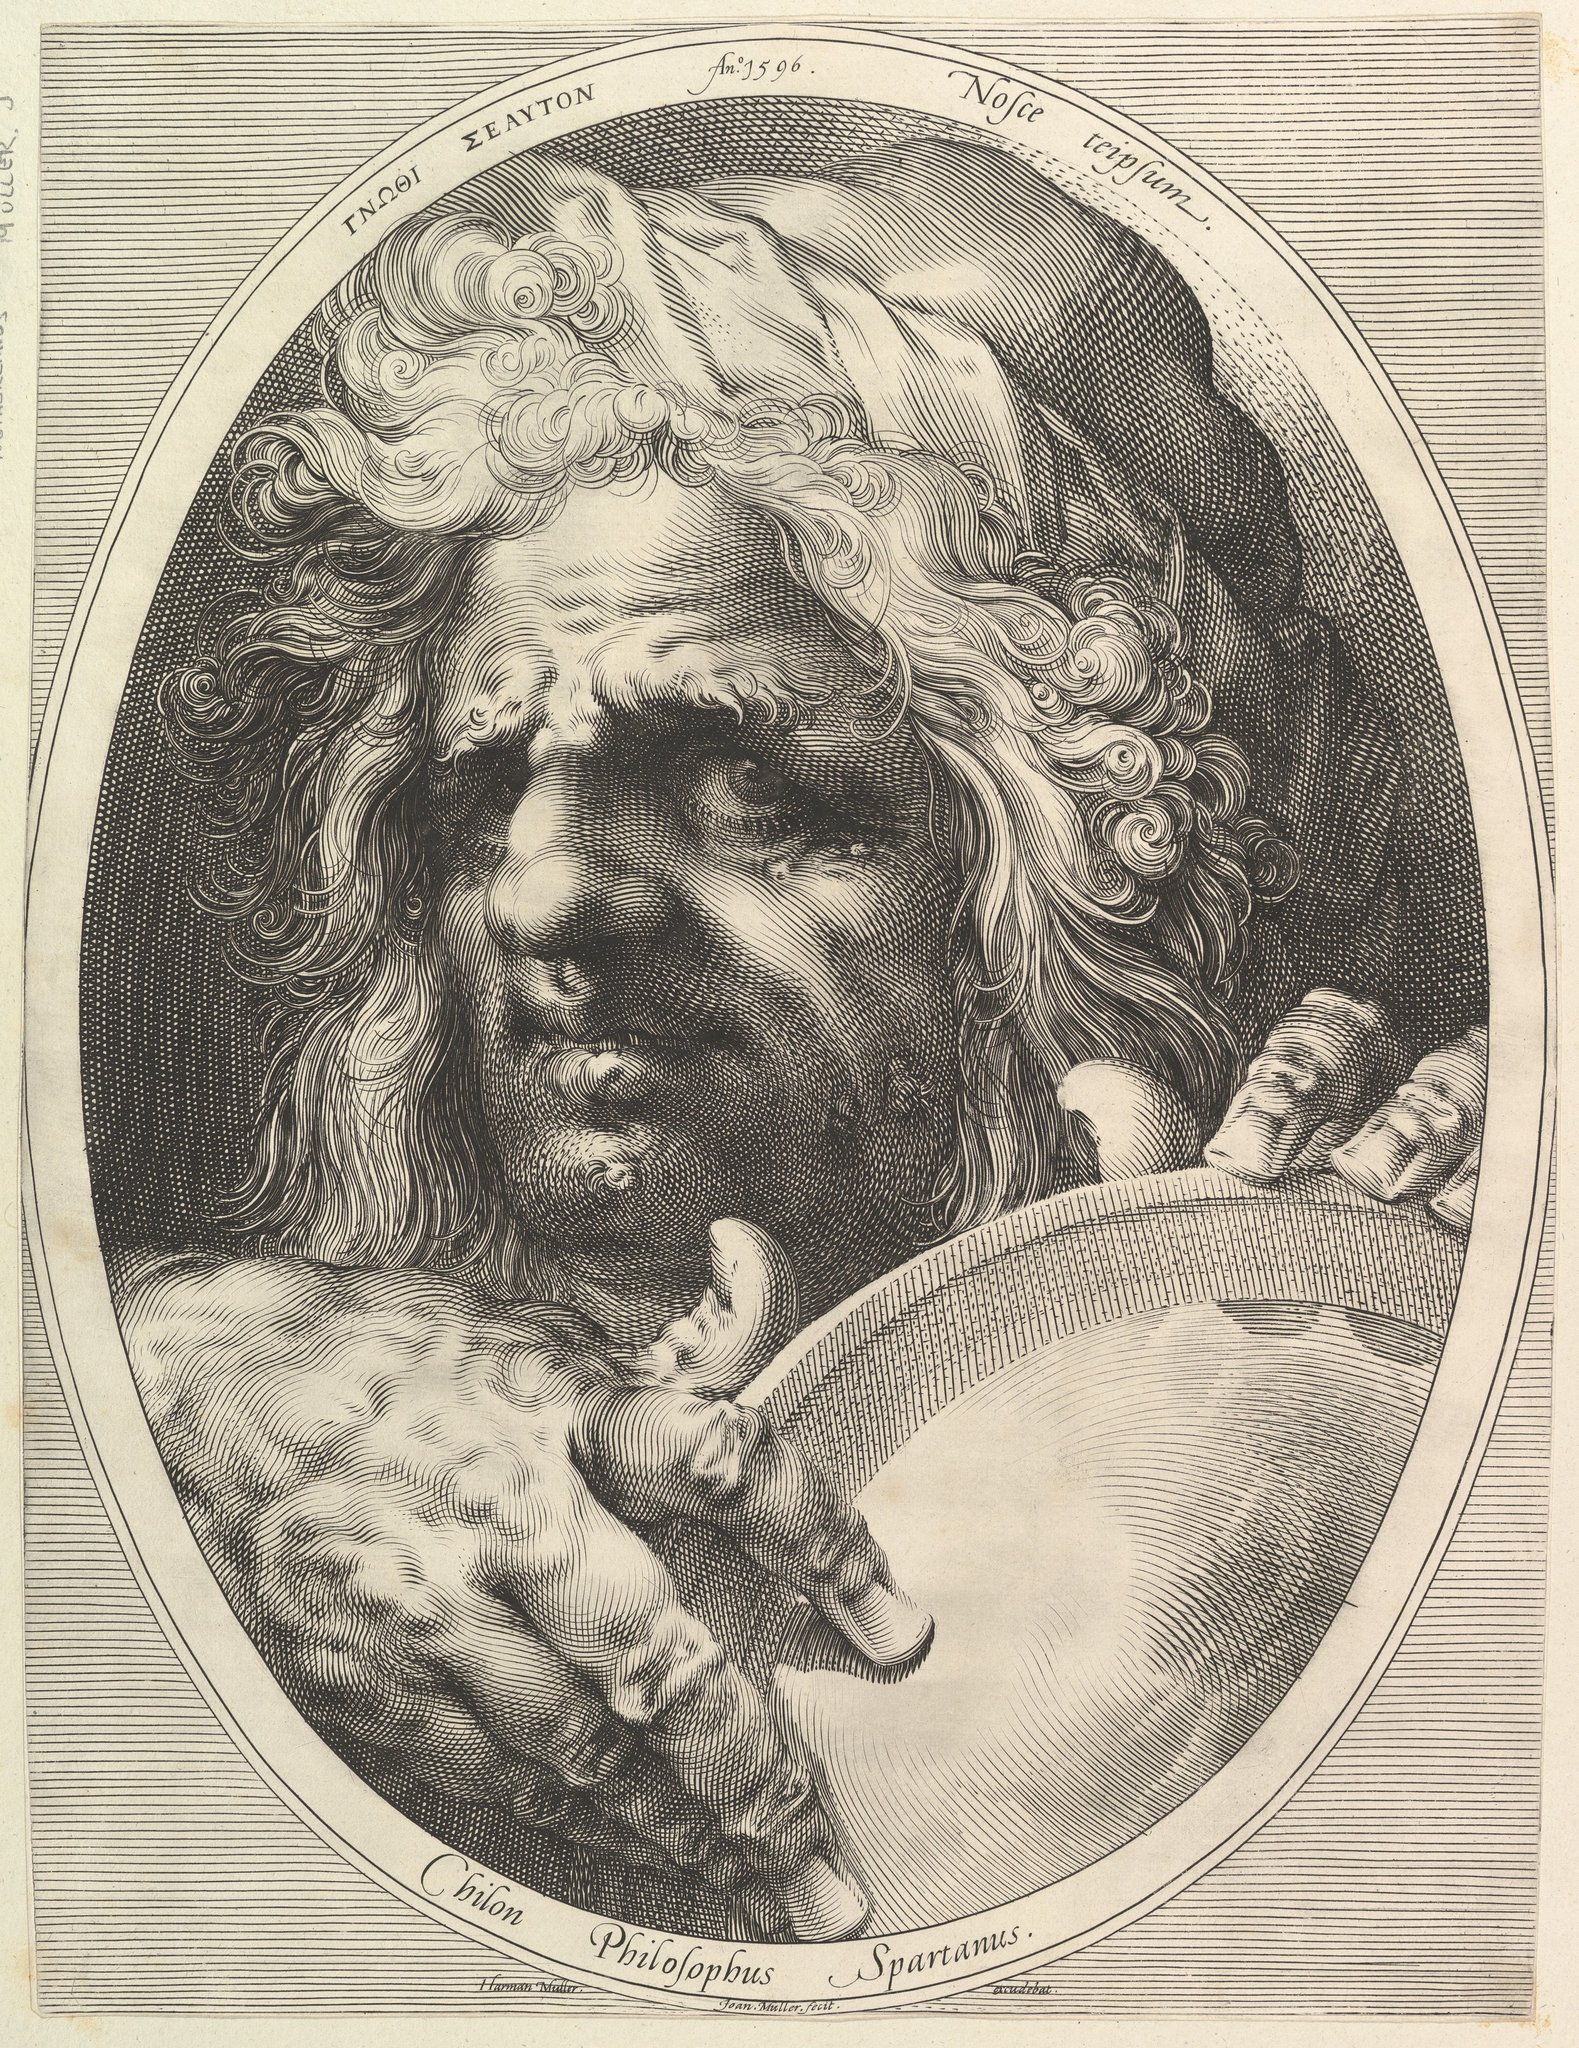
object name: print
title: Chilon, Spartan Philosopher and Councilor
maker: jan muller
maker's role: artist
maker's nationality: netherlandish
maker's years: 1571-1628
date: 1596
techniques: engraving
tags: men,portraits